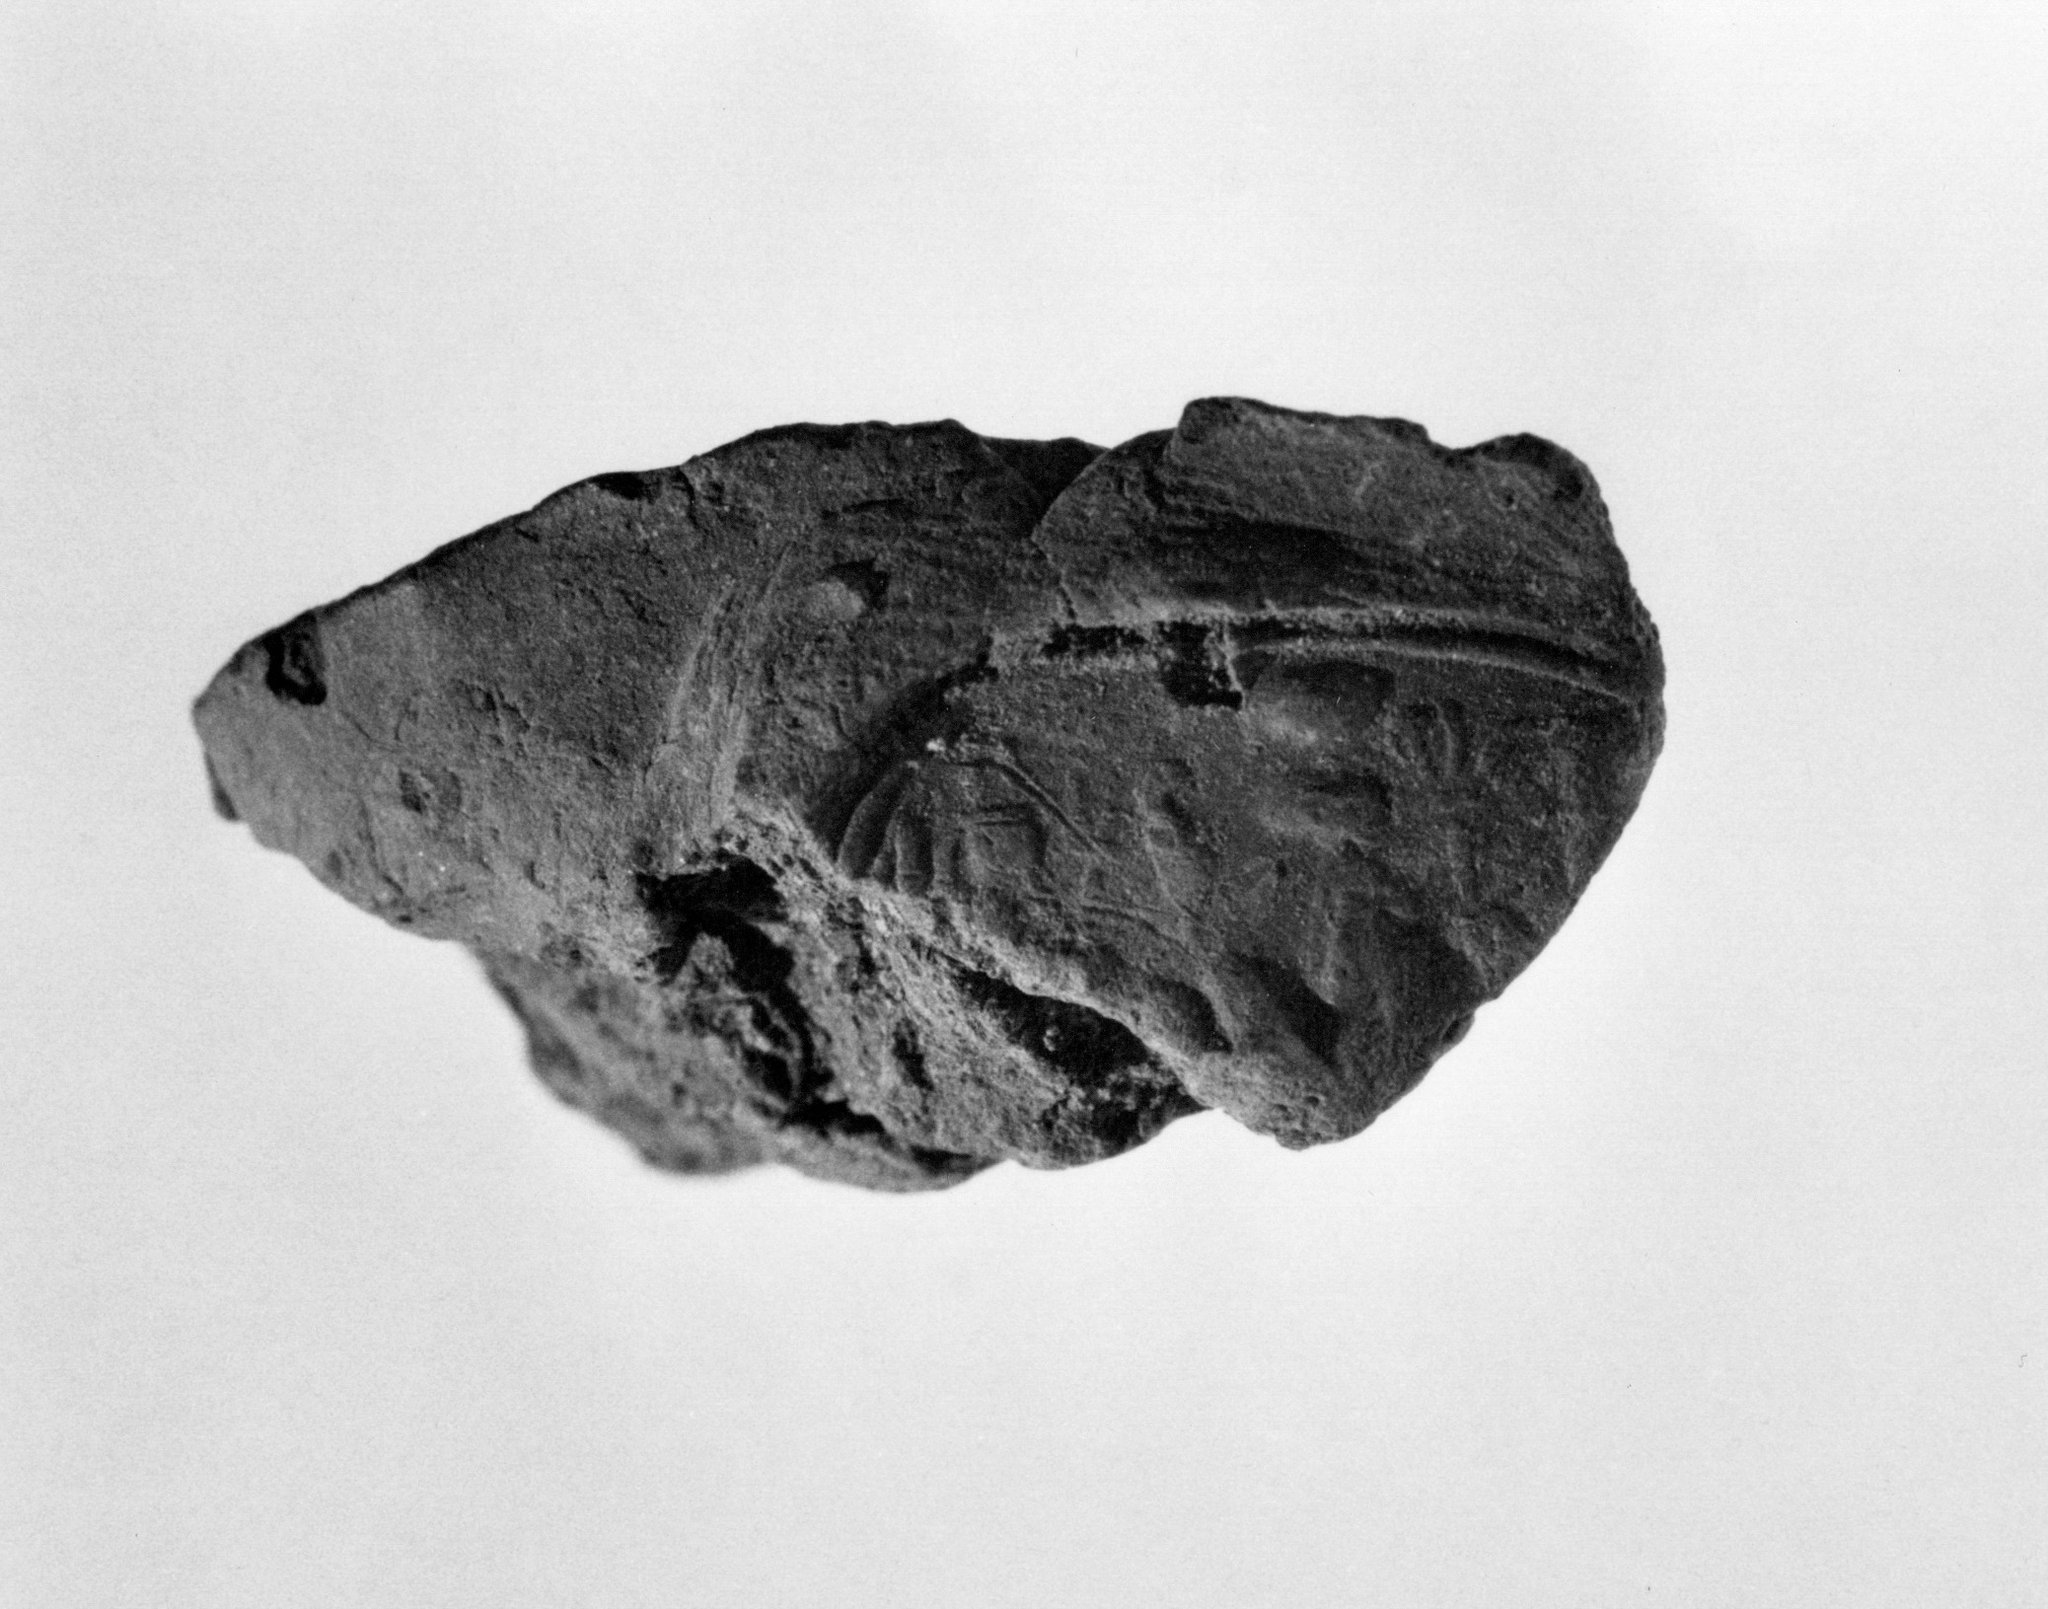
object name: sealing, nebmaatre, amenhotep iii, horus, re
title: Document Sealing With the Throne Name of Amenhotep III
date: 1390-1352 BCE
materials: mud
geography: egypt